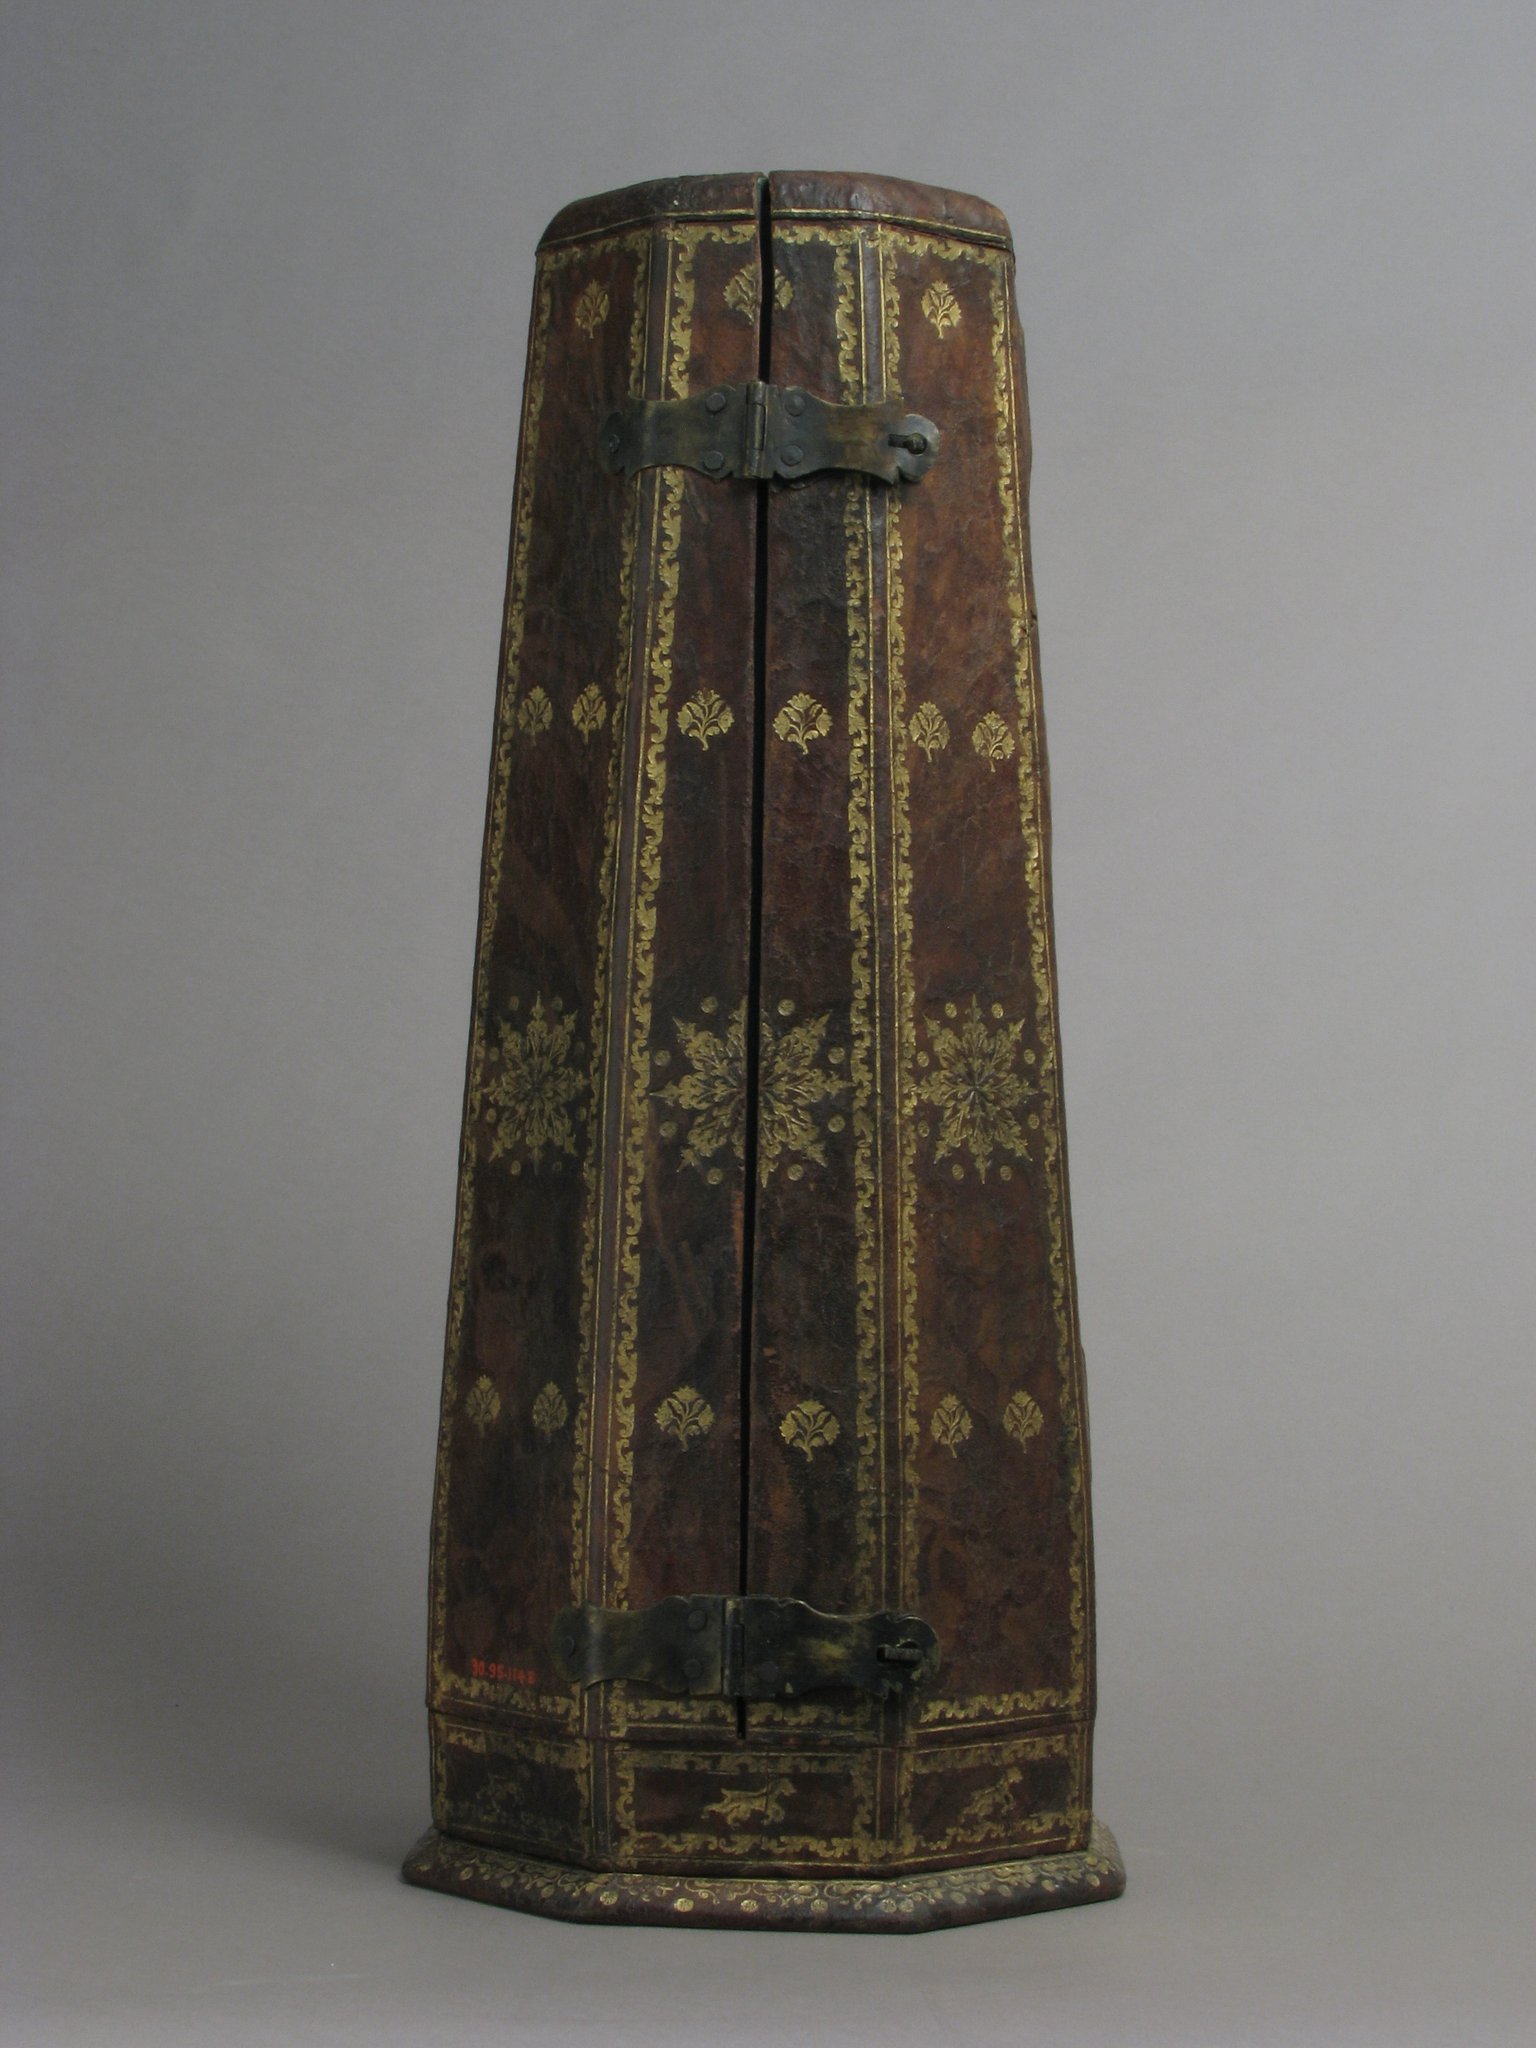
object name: case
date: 1701-1800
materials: gold, leather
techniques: tooling